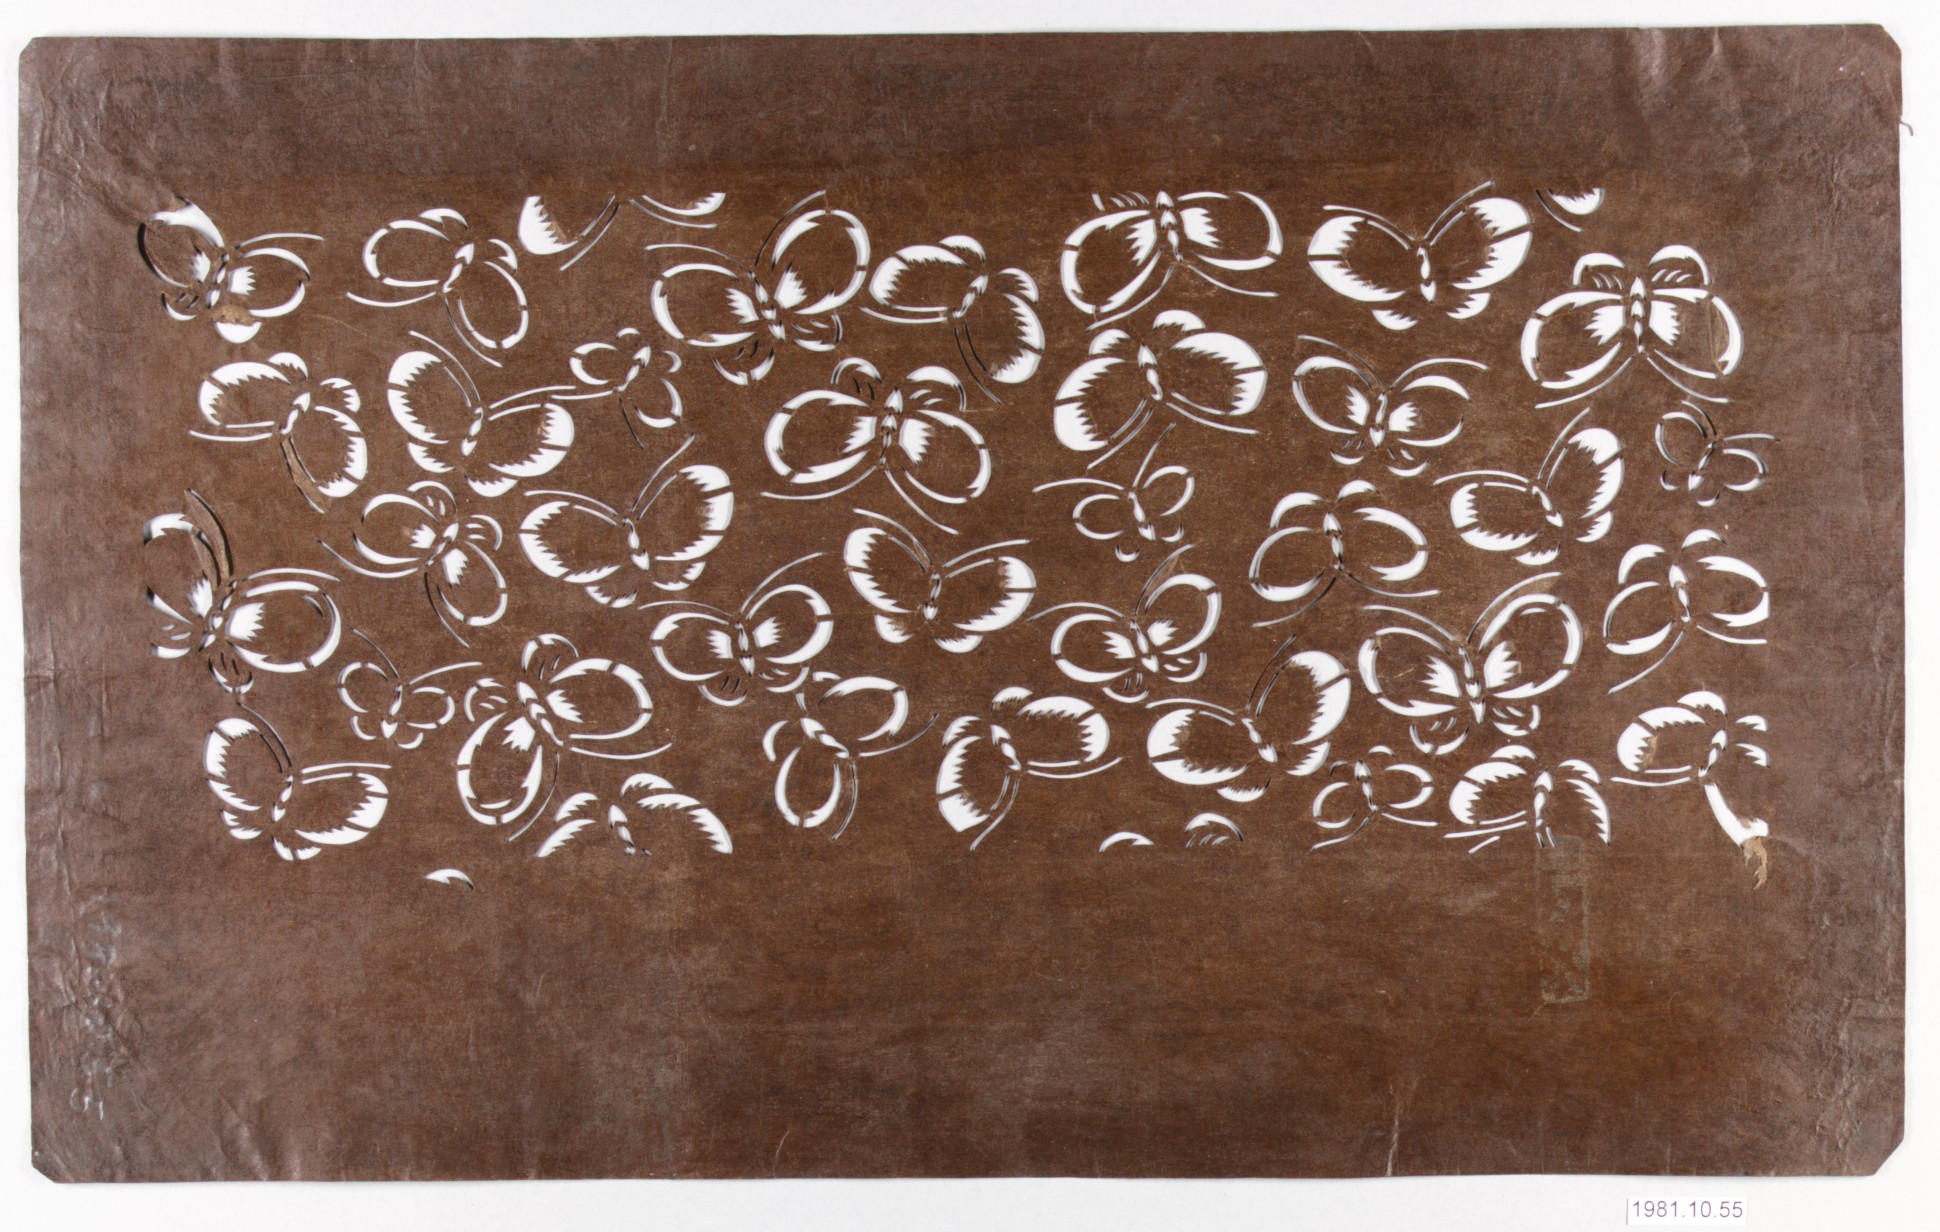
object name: stencil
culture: japanese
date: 1801-1900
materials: paper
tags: butterflies